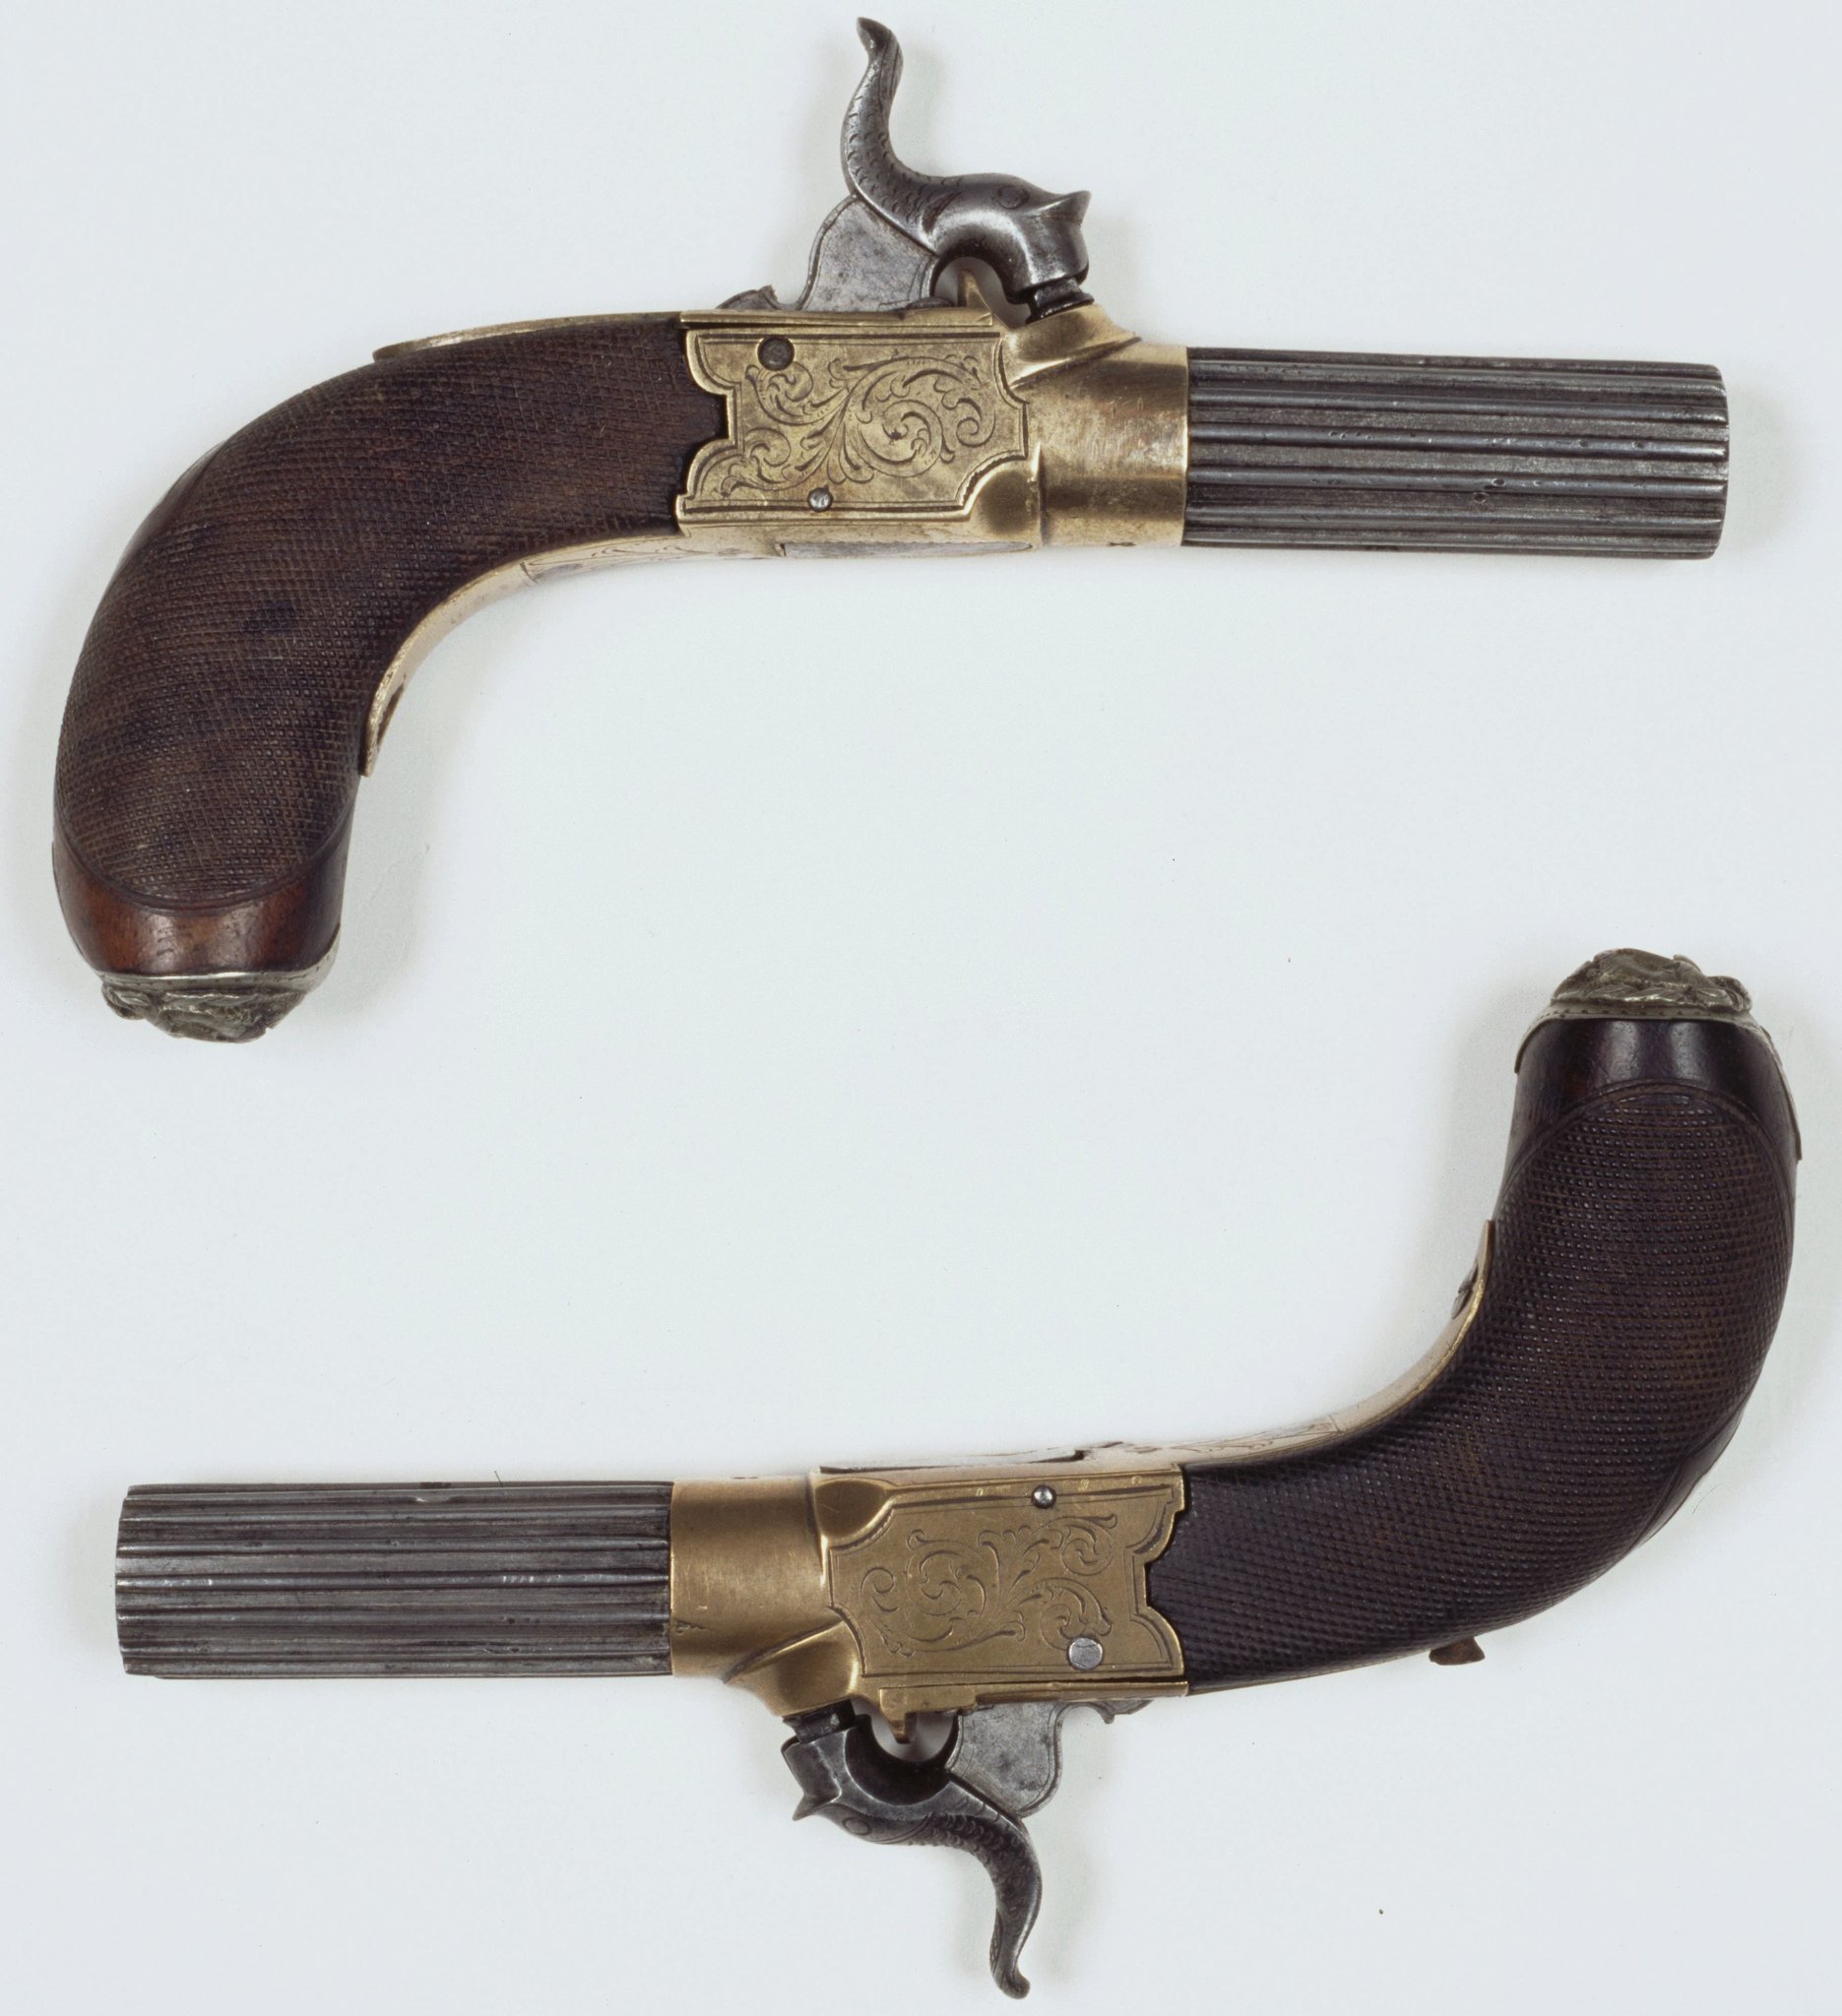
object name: percussion pistol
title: Percussiepistool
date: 1833-1870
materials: copper, iron, metal alloy, wood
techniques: engraving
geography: liverpool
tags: netherlands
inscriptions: mark: ‘LIVERPOOL’, mark: ‘WILLIAMS & POWELL’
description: Schots model van een percussiepistool met ingebouwd slot, ijzeren geribbelde loop, koperen slotplaat, houten kolf en witmetalen kolfkap. De loop is aan de buitenzijde geribbeld en aan de binnenzijde getrokken. De koperen slotplaat is aan beide zijden gegraveerd met lofwerk, aan de linkerzijde de naam van de vervaardiger. De kolf heeft een ruitmotief van hout en de greep is fijn geribbeld, de kolfkap aan de onderzijde is van witmetaal waar een leeuwenkop van is gemaakt.